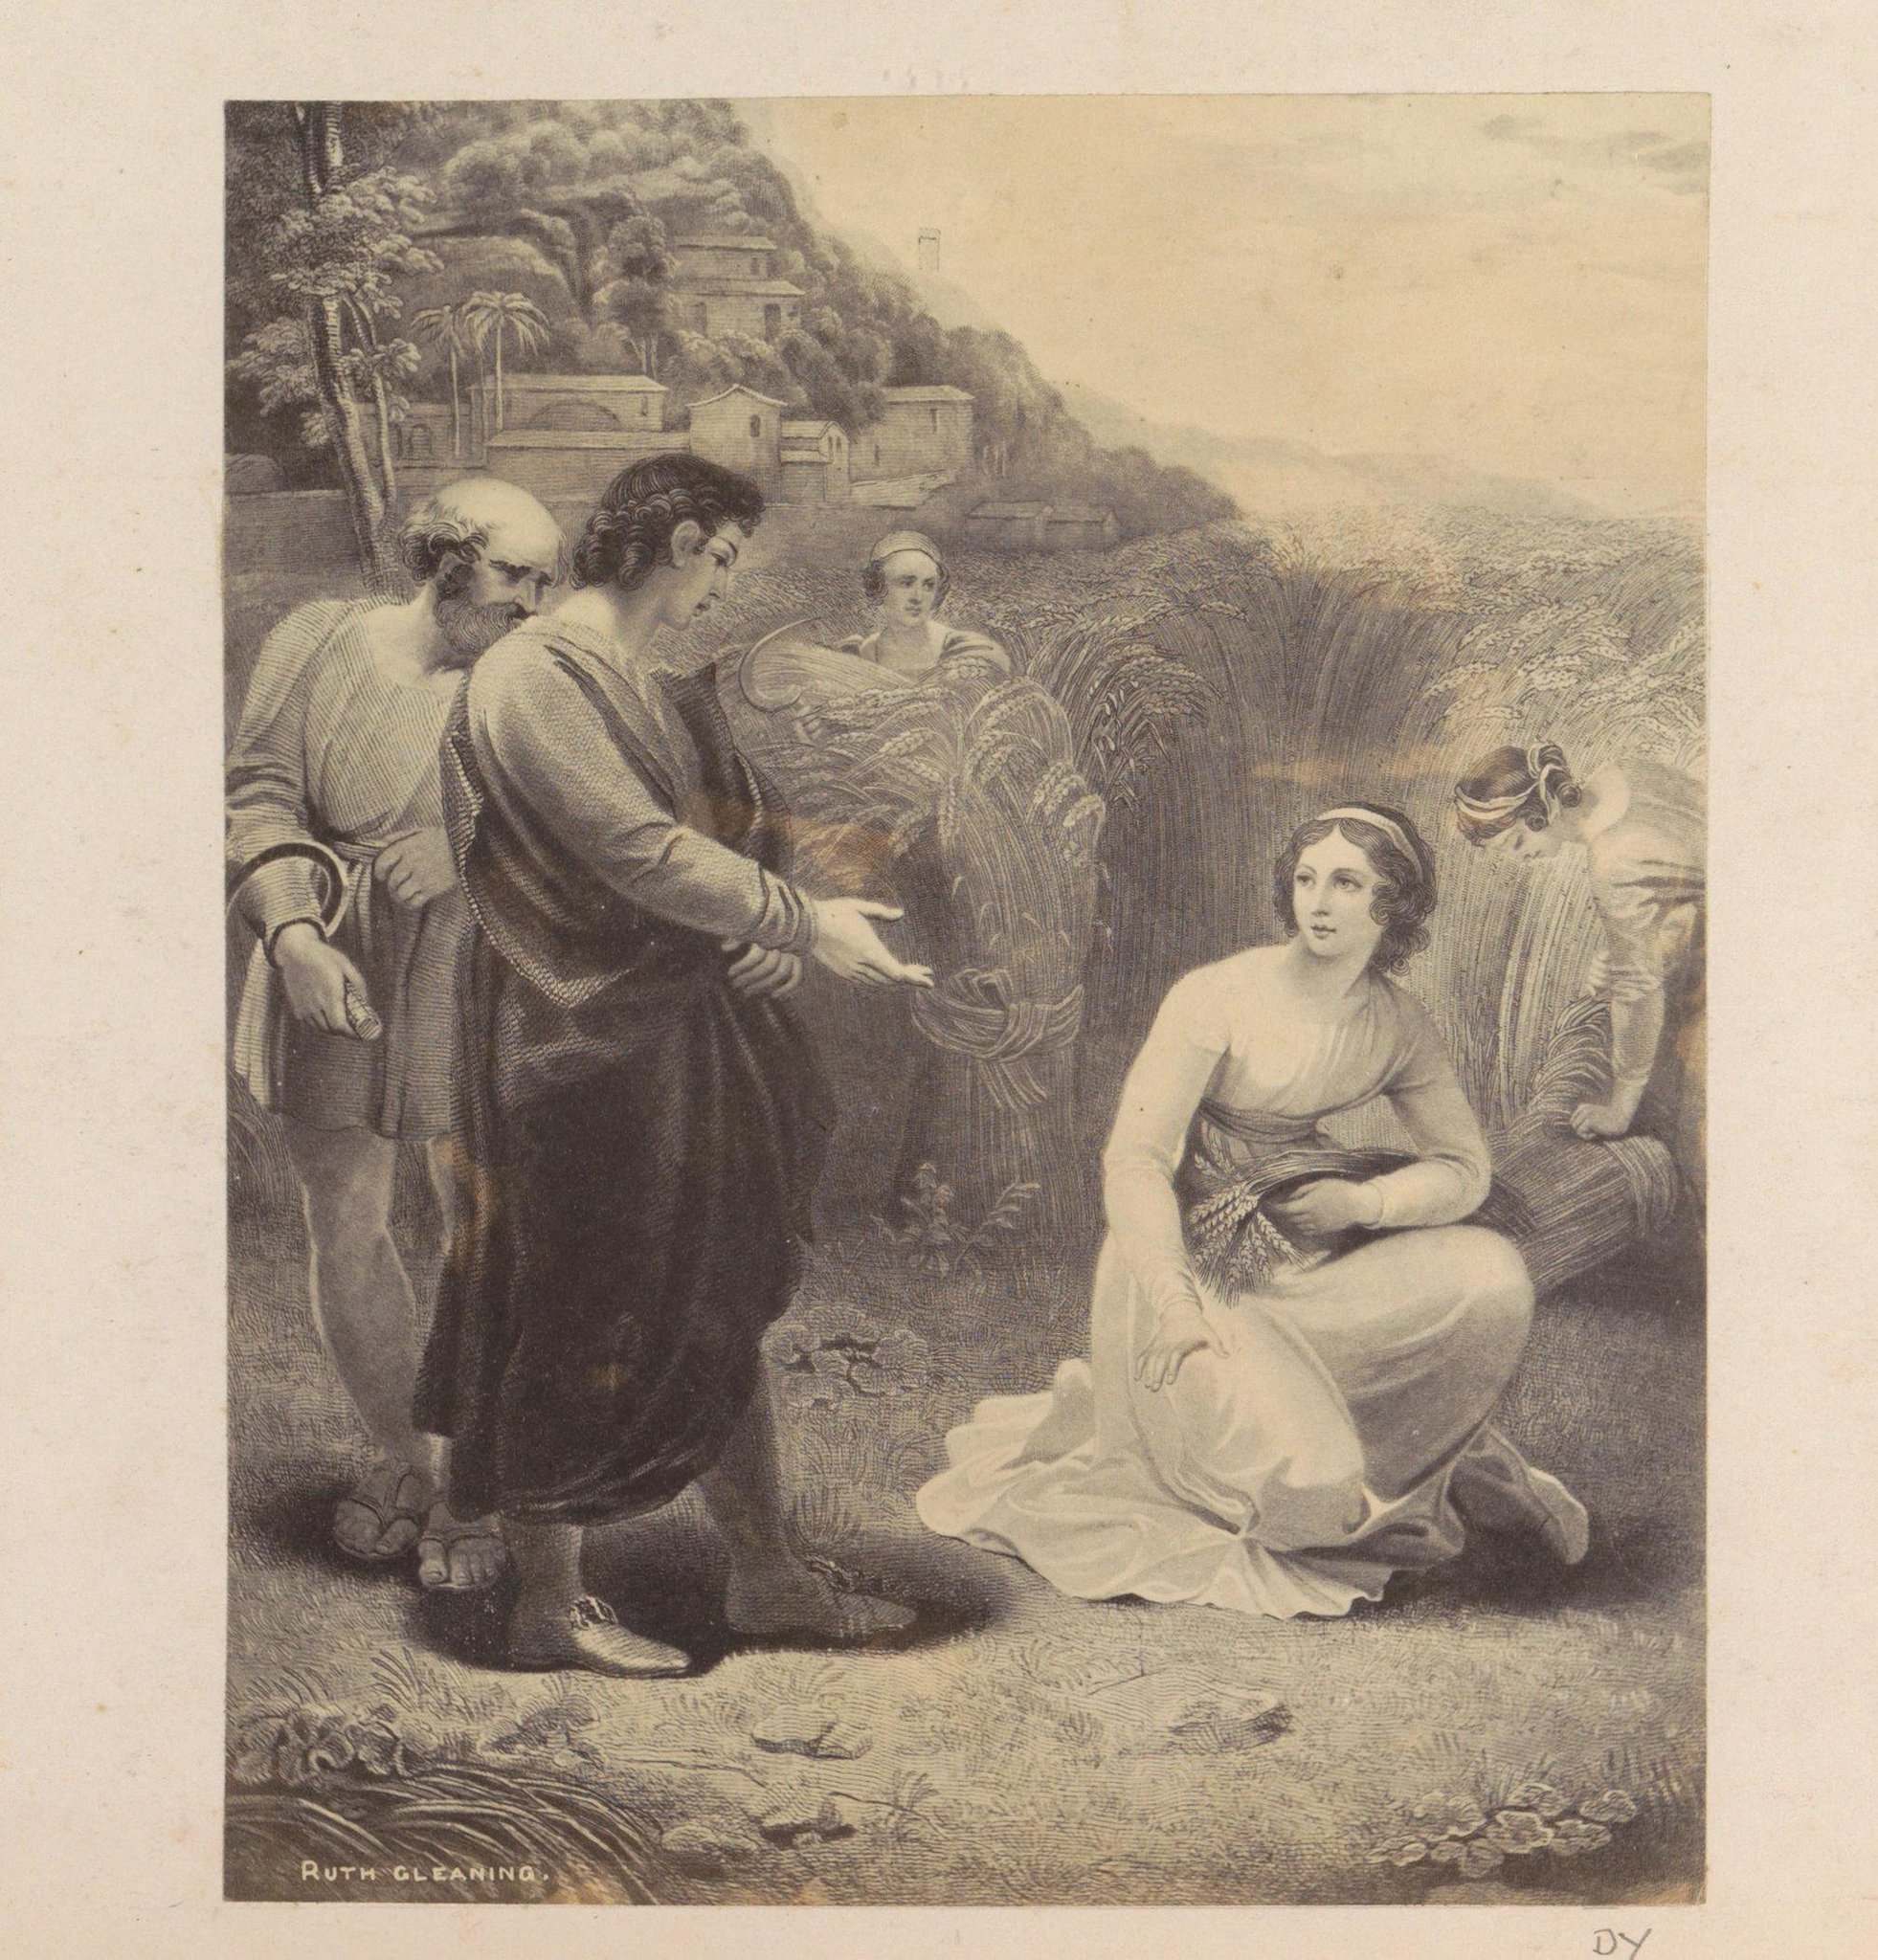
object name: photograph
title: Ruth gleaning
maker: Anonymous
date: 1850-1870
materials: paper, photographic support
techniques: albumen print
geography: england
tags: ruth gleaning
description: Onderdeel van Album met foto's van bezienswaardigheden en landschappen in Engeland en van kunst.